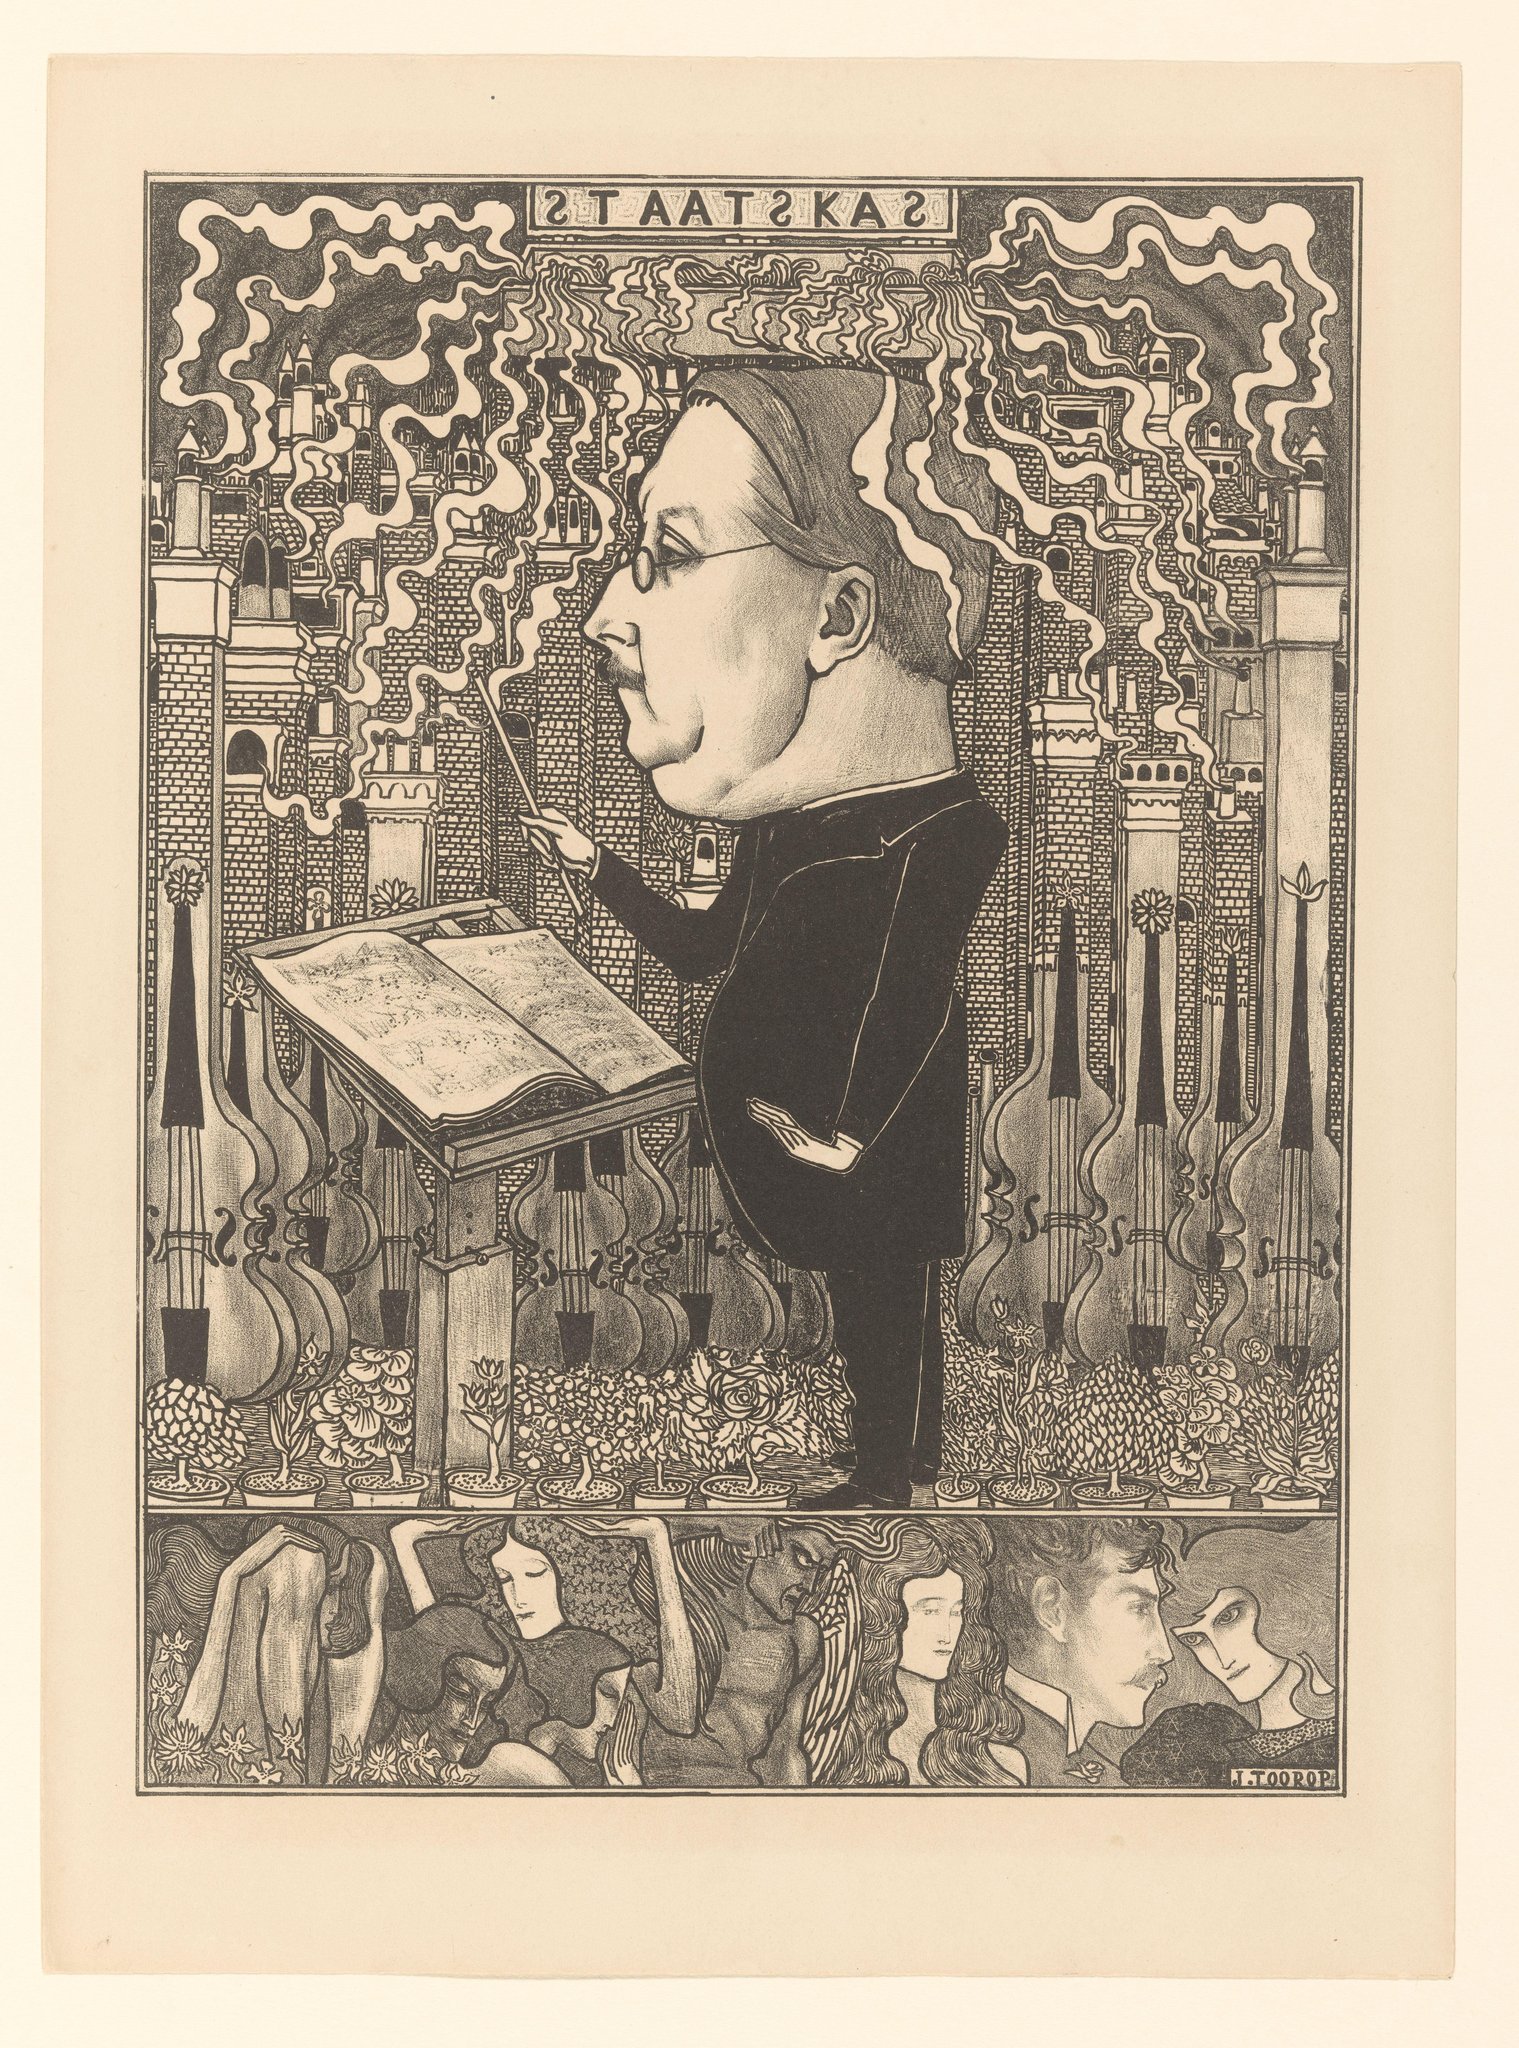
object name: cartoon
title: Dirigent met daarachter violen en rokende schoorstenen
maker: jan toorop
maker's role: draughtsman, painter, print maker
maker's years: 1858-1928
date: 1895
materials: paper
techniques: lithograph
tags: conductor ~ music, taxes and financial administration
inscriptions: collector's mark: Lugt 2228, collector's mark: Lugt 2760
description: Op 2 juni 1985 verscheen een reproductie van deze prent als bijvoegsel van het tijdschrift 'De Kroniek'.